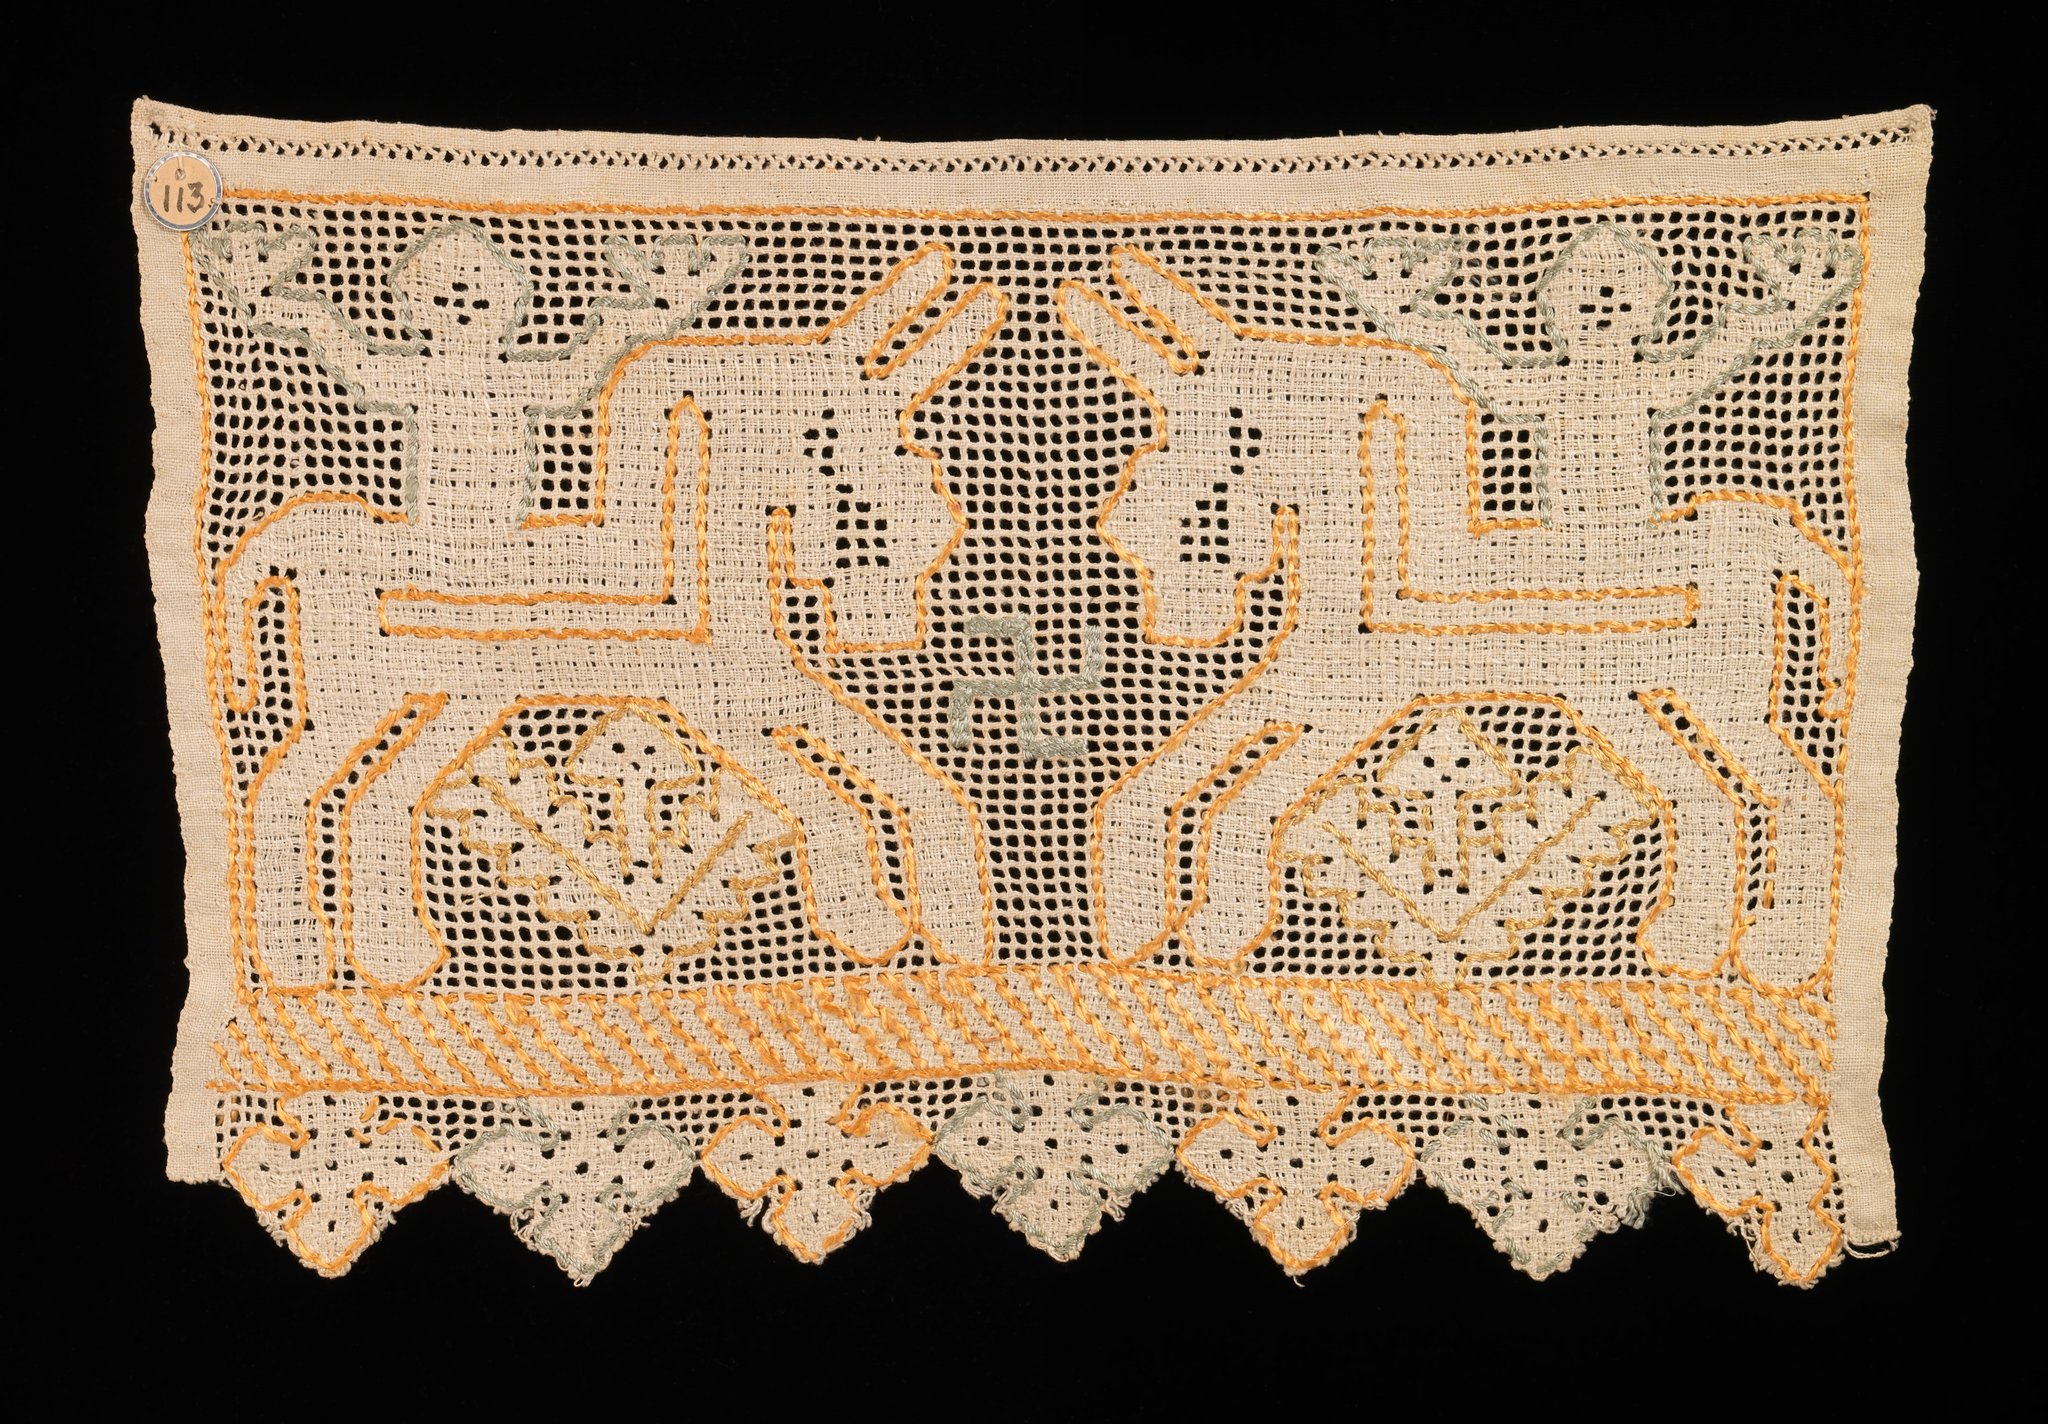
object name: textile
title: Towel border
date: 1801-1833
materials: linen, silk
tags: human figures,animals